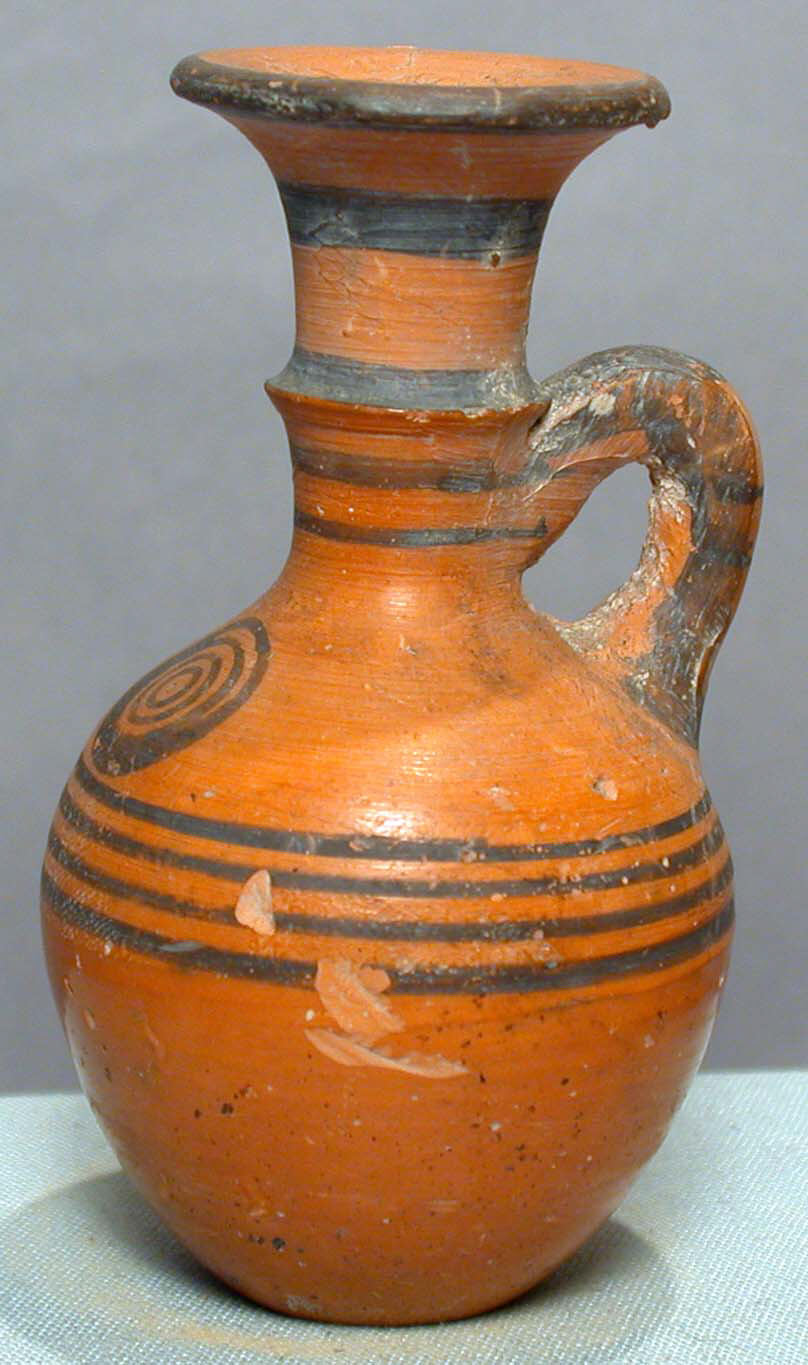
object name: jug, miniature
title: Terracotta miniature jug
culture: cypriot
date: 800-701 BCE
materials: terracotta